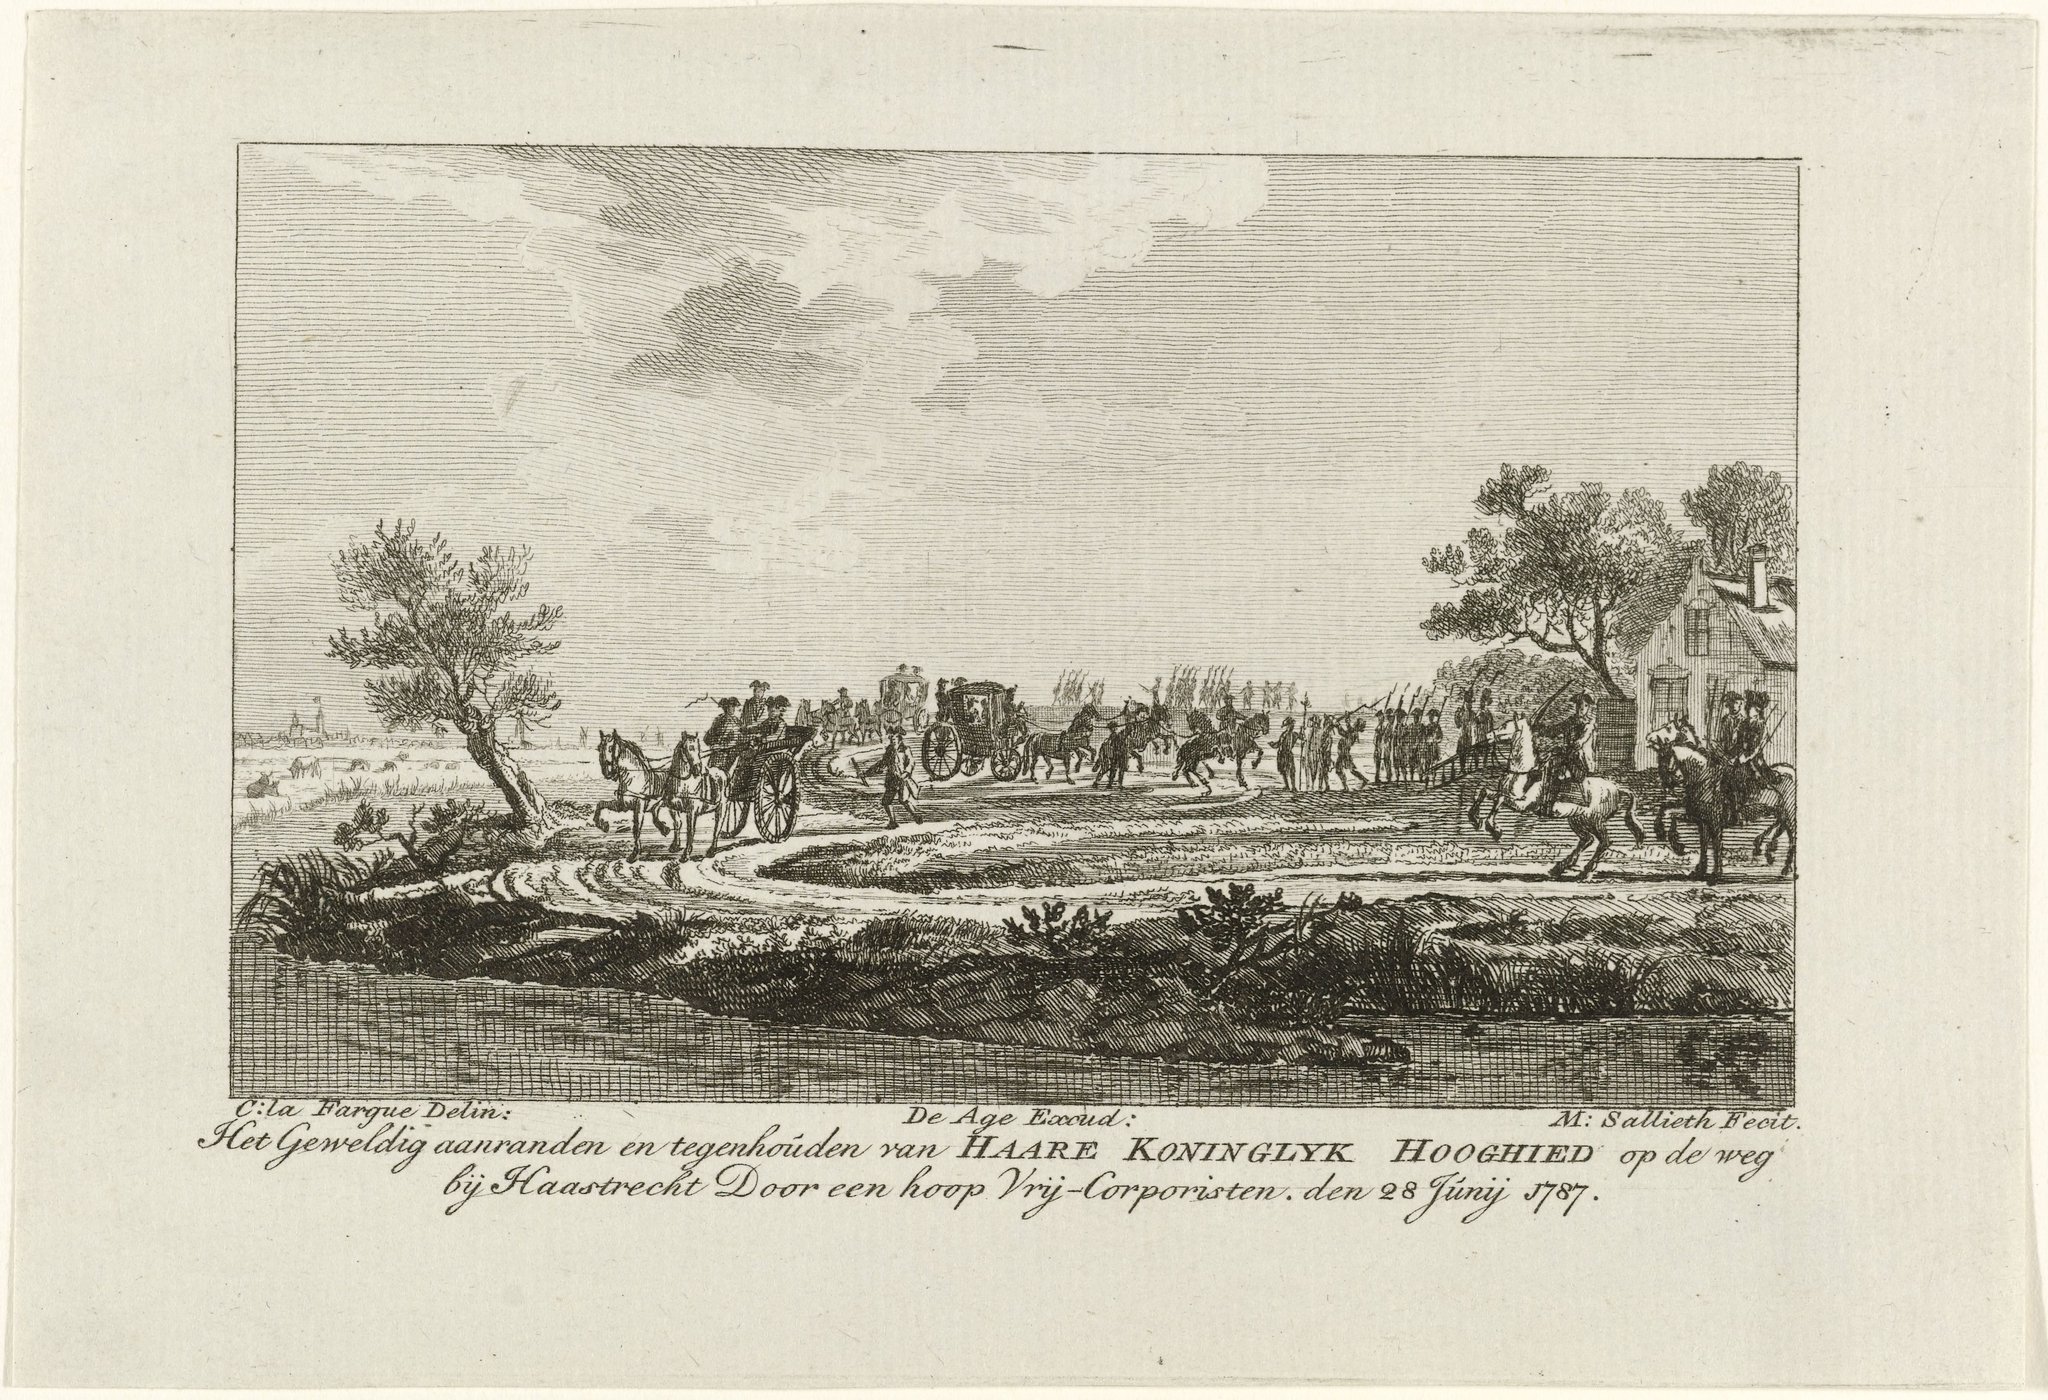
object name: print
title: Het geweldig aanranden en tegenhouden van Haare Koninglyk Hooghied op de weg bij Haastrecht door een hoop Vrij-Corporisten. den 28 junij 1787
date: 1787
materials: paper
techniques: engraving, etching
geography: northern netherlands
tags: berlin, painter, draughtsman, wilhelmina of prussia (princess of orange), arrest (of criminal)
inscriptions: collector's mark: Lugt 2228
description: Prent ook gebruikt in: De Haagsche princelyke en koninglyke almanach, voor het schrikkeljaar 1788. Met plaaten. Den Haag: Johannes François Jacobs de Agé, 1788.